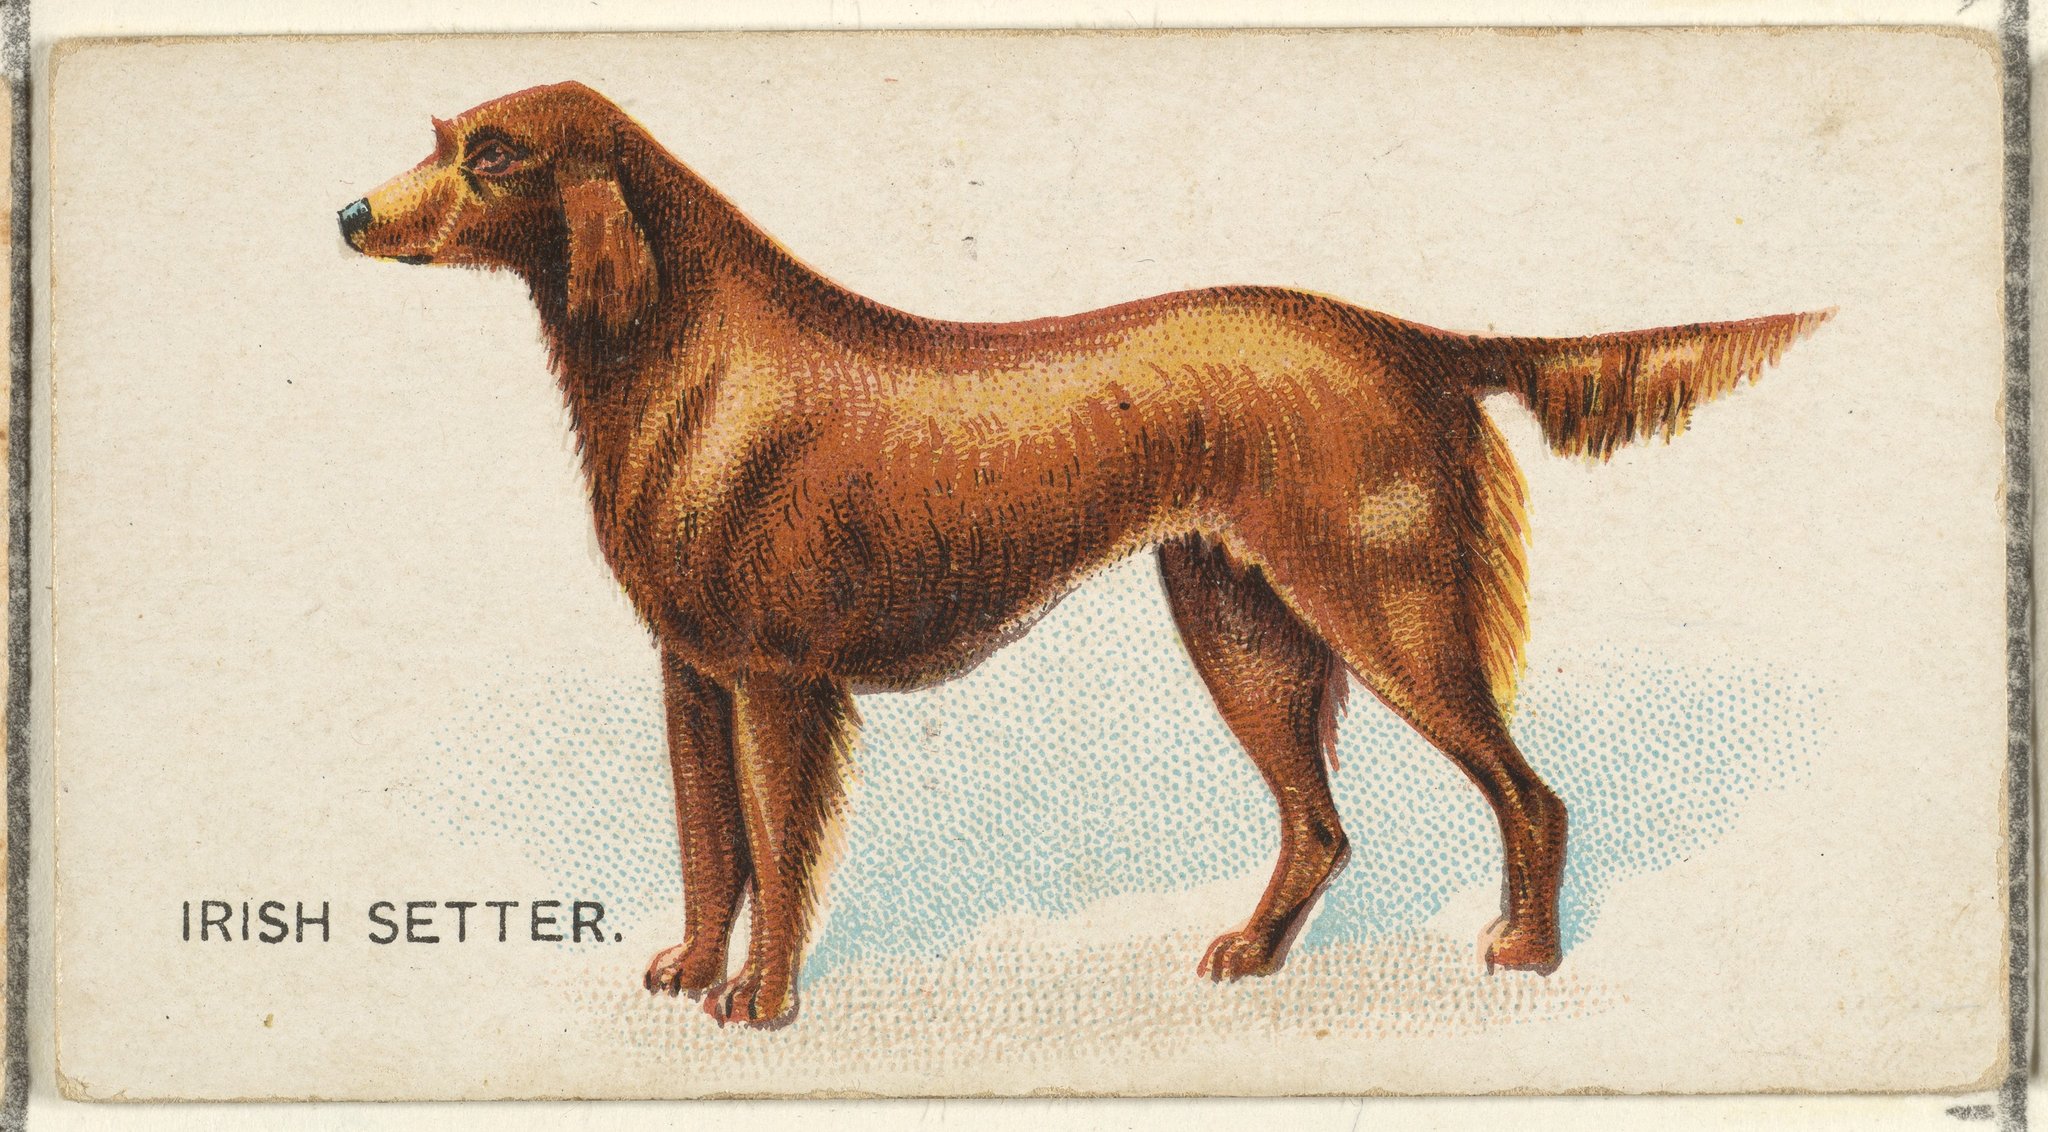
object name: print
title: Irish Setter, from the Dogs of the World series for Old Judge Cigarettes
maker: goodwin & company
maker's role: publisher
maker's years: 1850-1950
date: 1890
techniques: color lithograph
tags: dogs